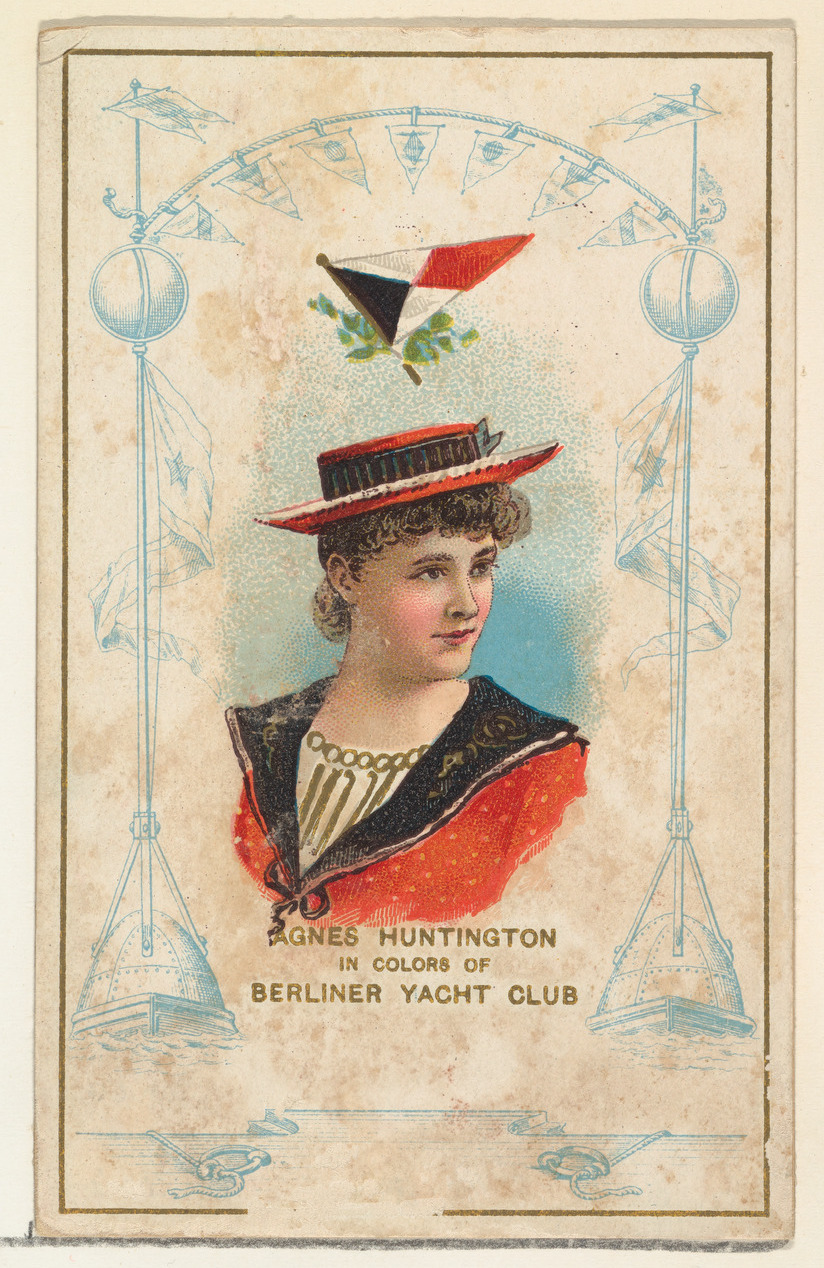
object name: print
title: Agnes Huntington in Colors of the Berliner Yach Club, from the Yacht Colors of the World series (N140) issued by Duke Sons & Co. to promote Honest Long Cut Tobacco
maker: w. duke, sons & co.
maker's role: publisher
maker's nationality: american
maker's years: 1870-1920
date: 1890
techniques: color lithograph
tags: portraits,women,flags